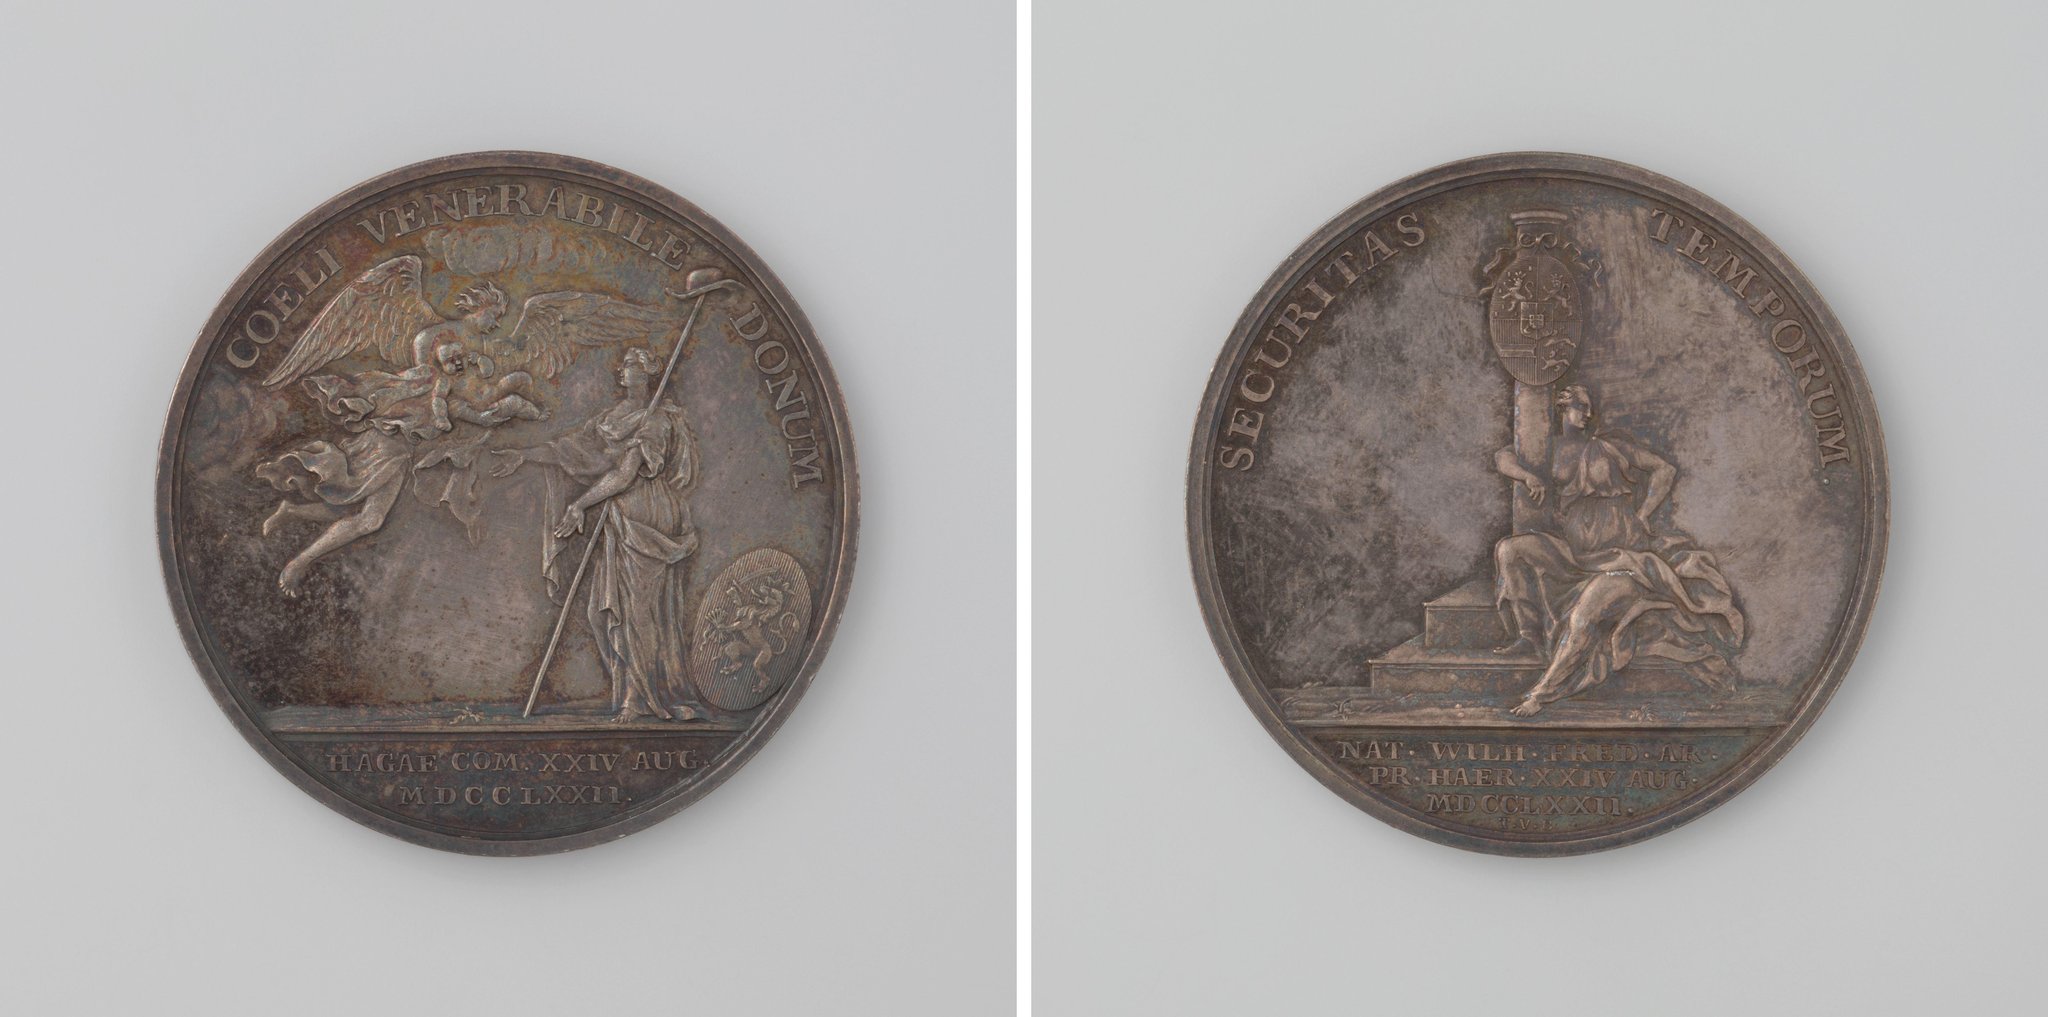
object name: history medal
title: Geboorte van Willem Frederik, erfprins van Oranje-Nassau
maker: theodorus victor van berckel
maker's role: mintmaster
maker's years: 1739-1808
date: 1772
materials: silver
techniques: striking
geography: brussels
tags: the hague, berlin, william i of the netherlands